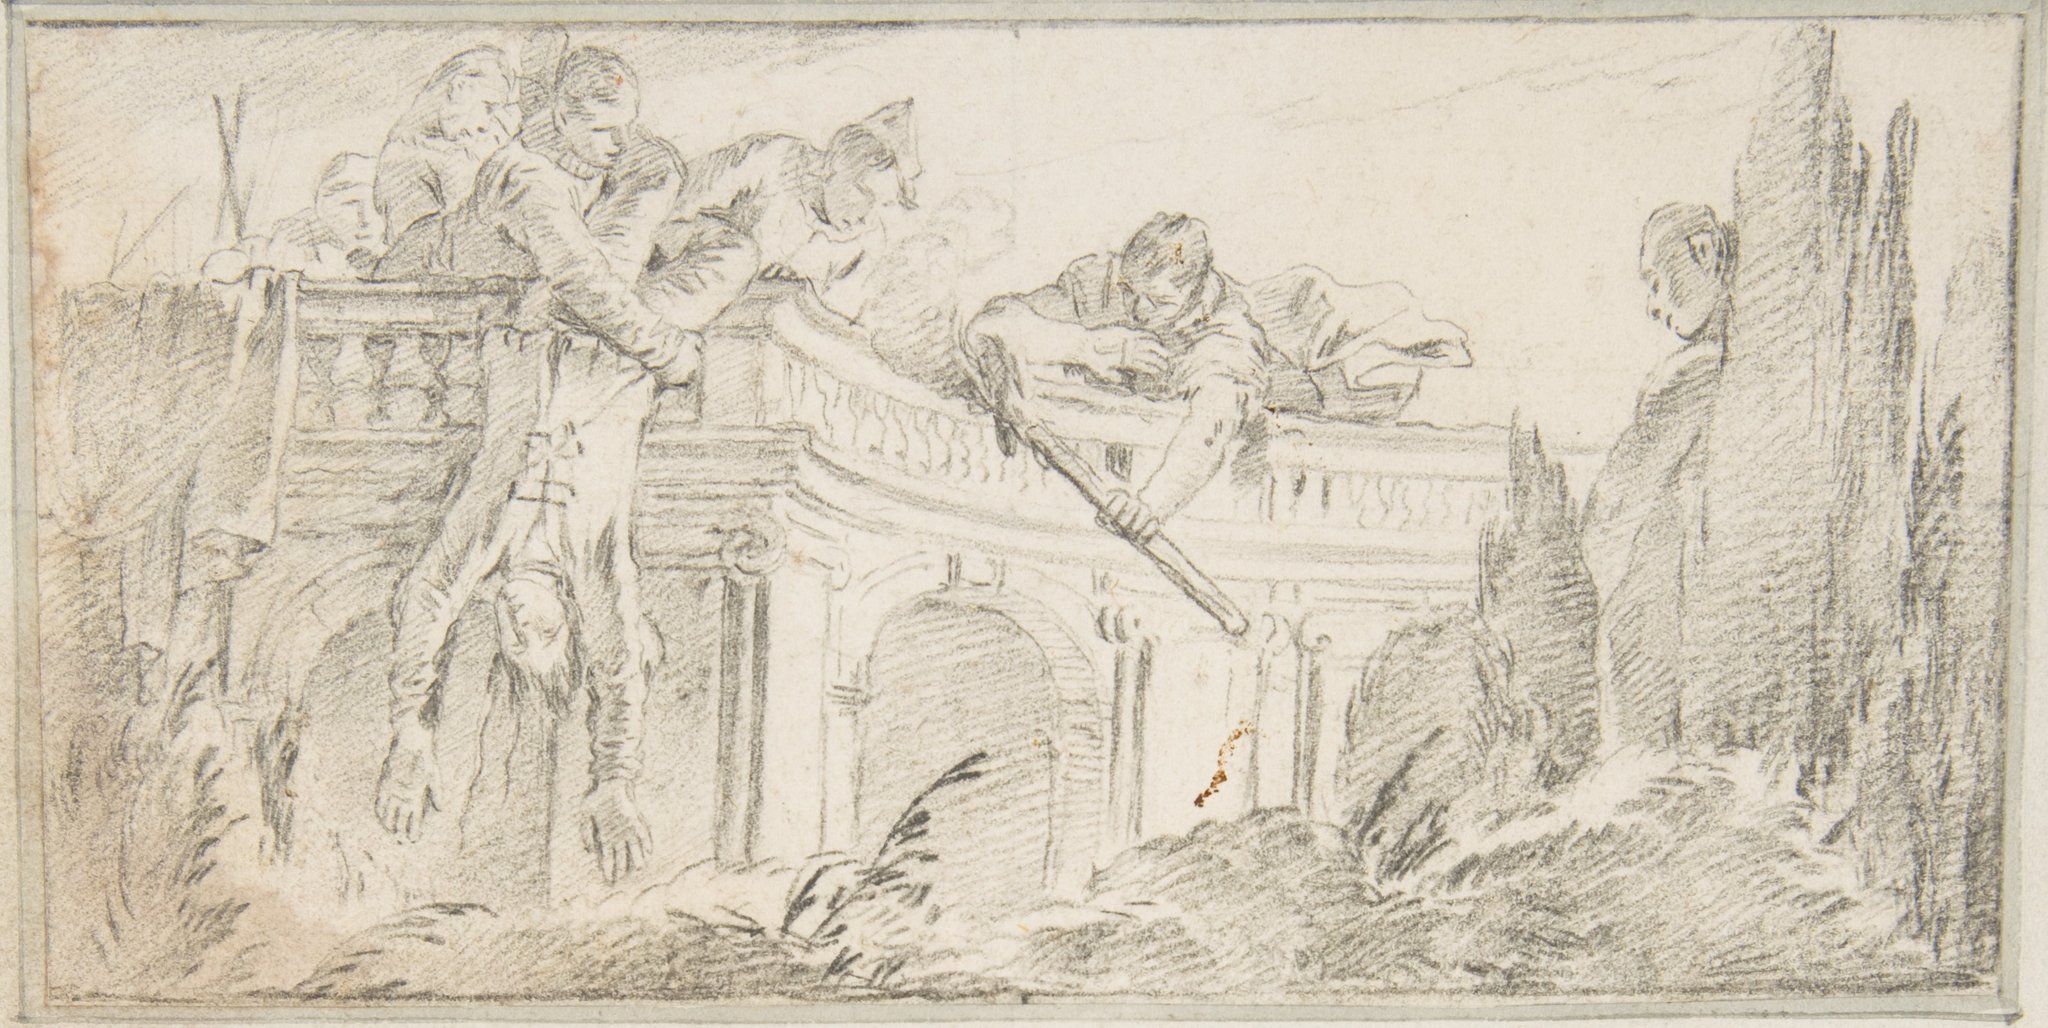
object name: drawing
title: Illustration for a Book: Scene of Men Disposing of Corpse in a Garden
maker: giovanni battista tiepolo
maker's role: artist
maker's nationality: italian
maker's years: 1696-1770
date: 1696-1770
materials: chalk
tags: human figures,gardens,corpses